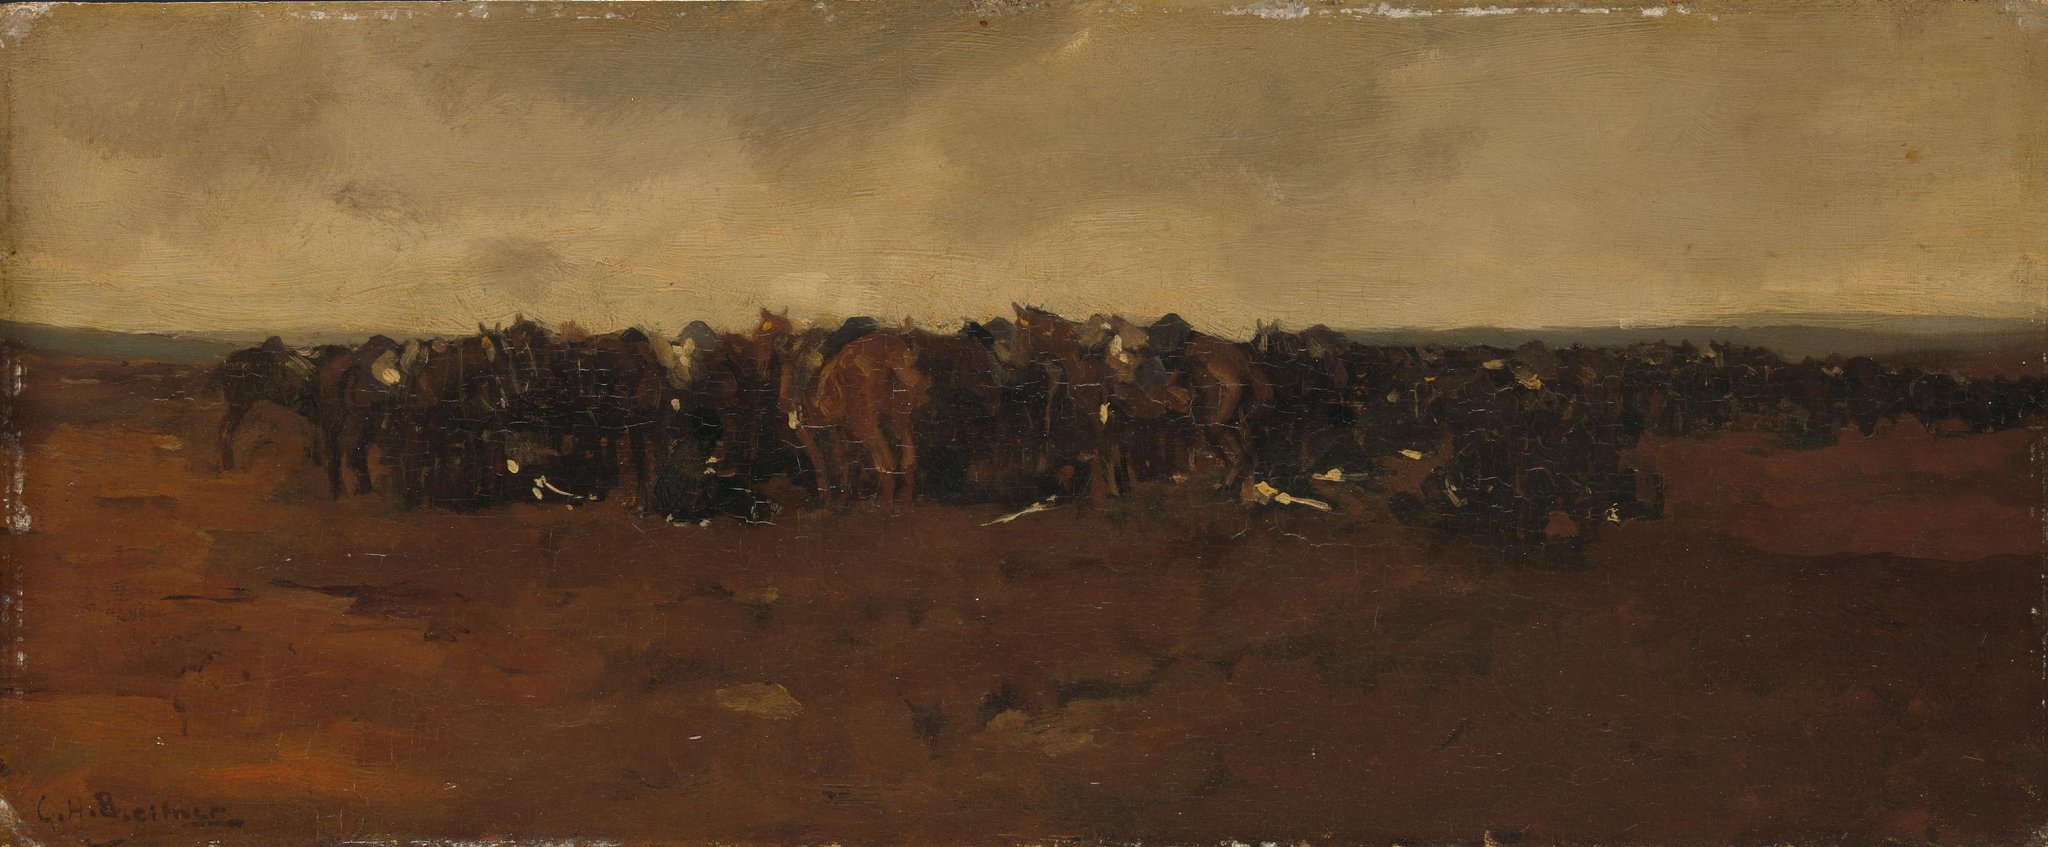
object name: painting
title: Cavalry at Repose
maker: george hendrik breitner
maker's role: draughtsman, painter, print maker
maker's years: 1857-1923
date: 1880-1890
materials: oil, panel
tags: military training (+ cavalry, horsemen)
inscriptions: signature: ‘G.H. Breitner’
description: Rustende cavalerie op een uitgestrekt manoeuvreveld.